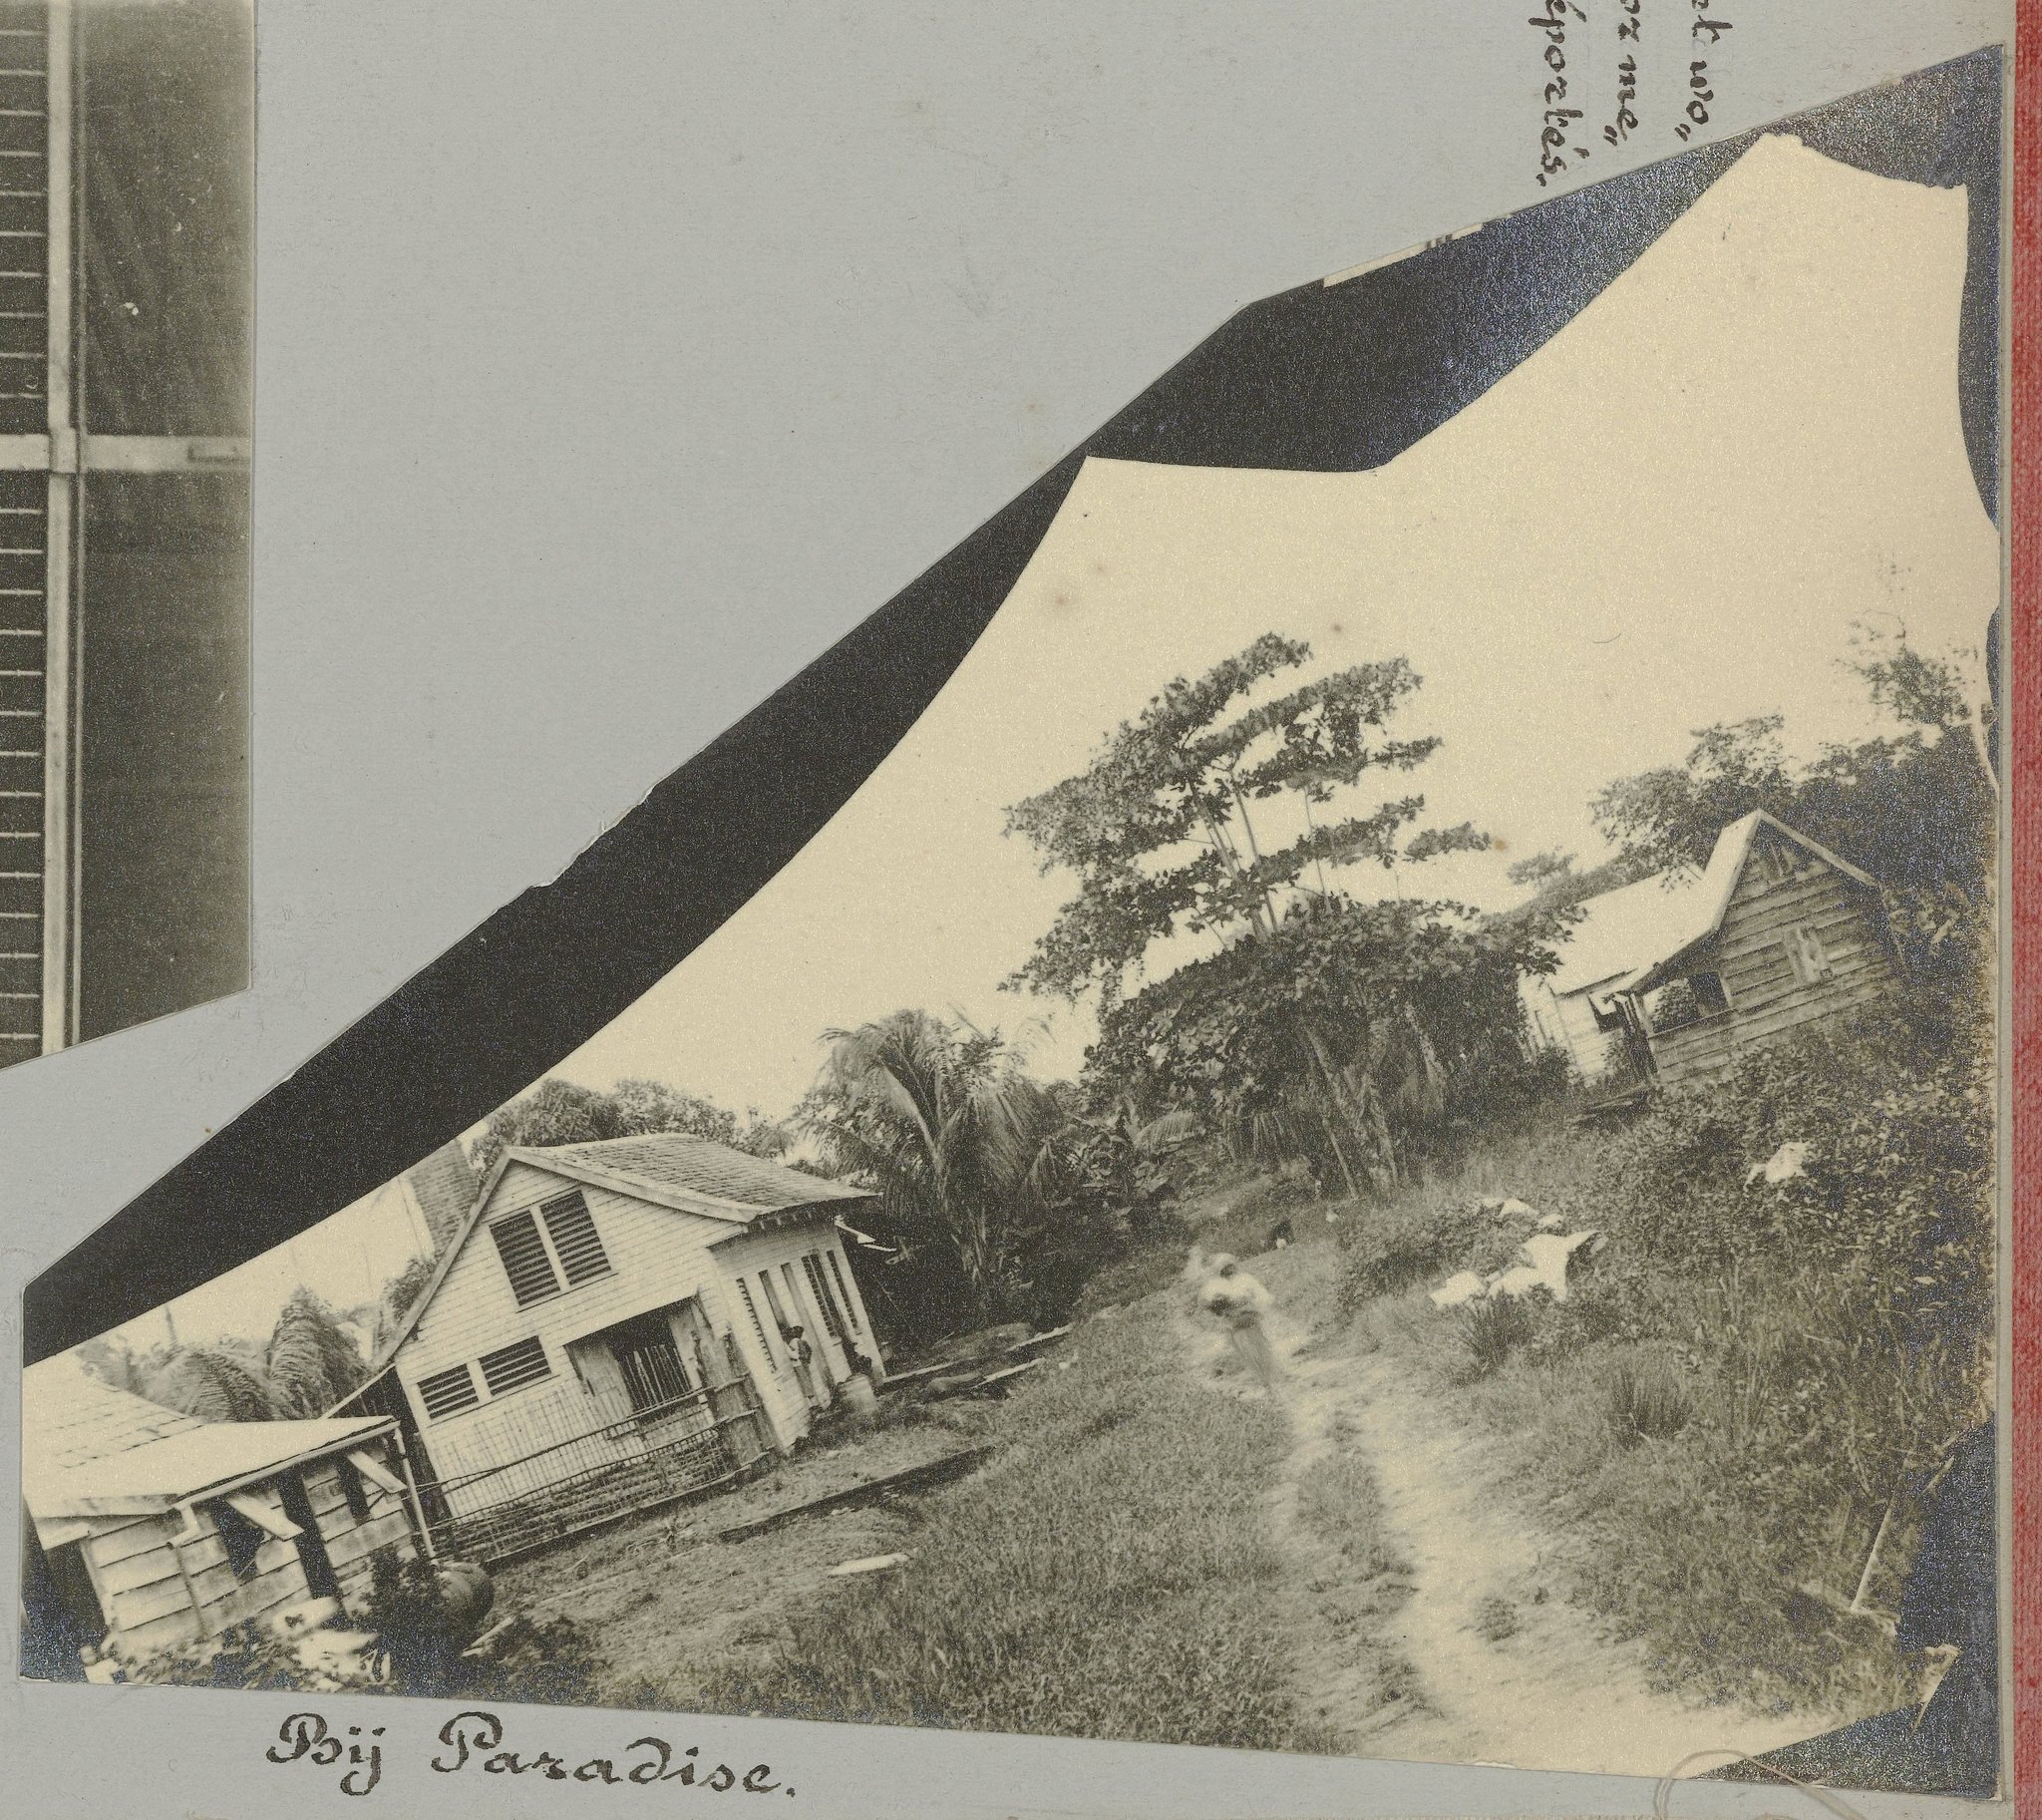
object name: photograph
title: Bij Paradise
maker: gomez burke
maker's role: fotograaf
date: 1891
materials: photographic support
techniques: gelatin silver print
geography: suriname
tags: suriname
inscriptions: inscription: ‘G.B. / Bij Paradise.’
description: Huizen bij de Plantage Paradise. Afdruk van een scherf van een glasnegatief. Onderdeel van het fotoalbum Souvenir de Voyage (deel 4), over het leven van de familie Dooyer in en rond de plantage Ma Retraite in Suriname in de jaren 1906-1913.